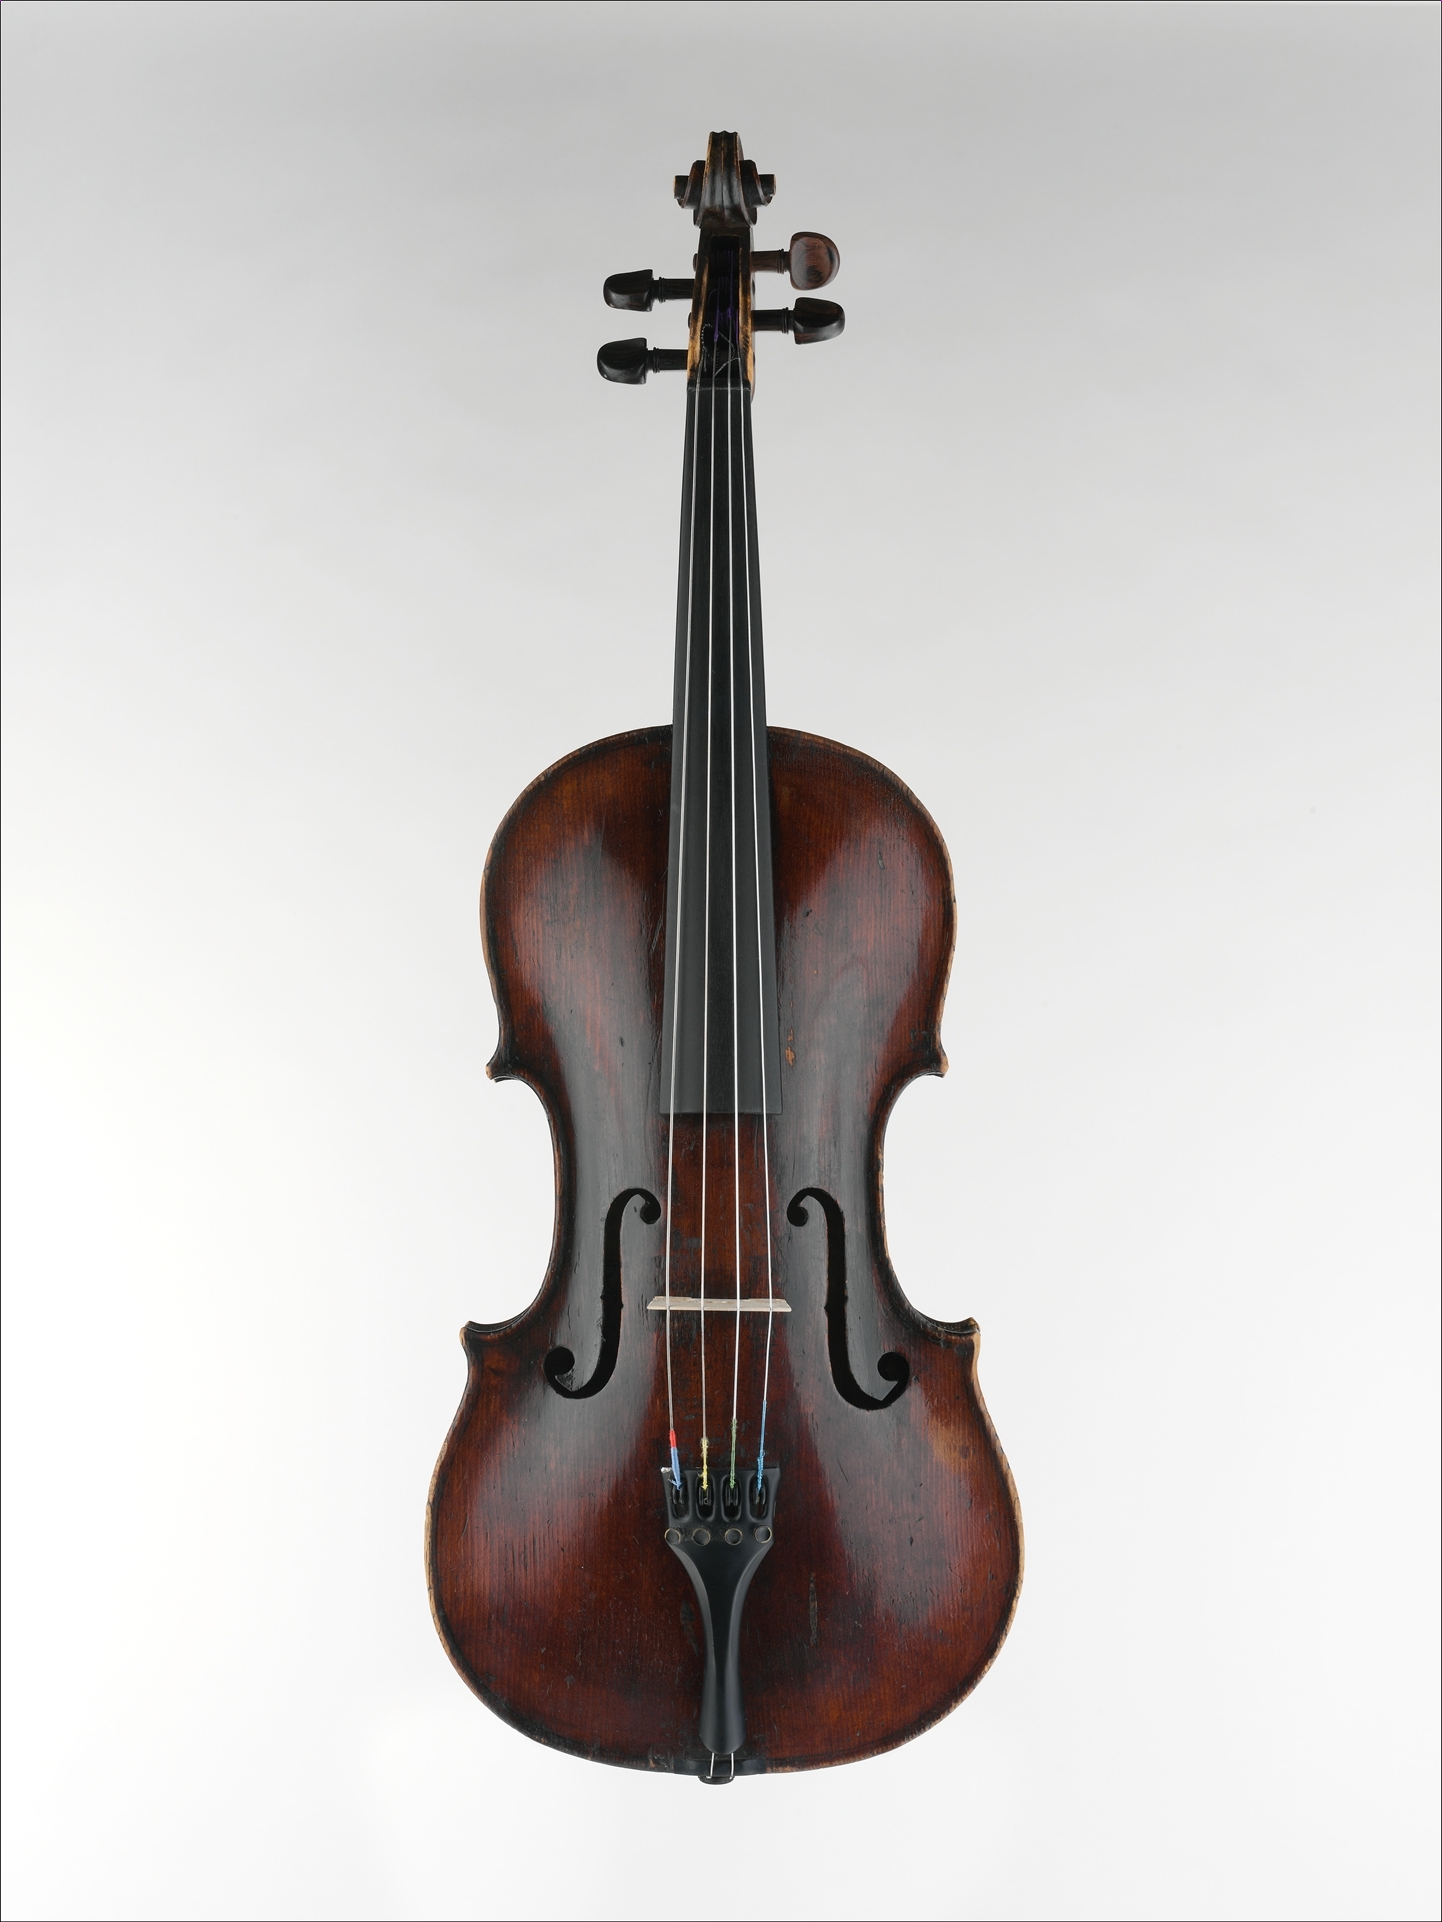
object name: viola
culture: american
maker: robert horne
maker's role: maker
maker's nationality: british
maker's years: 1767-1773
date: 1757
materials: wood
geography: united states